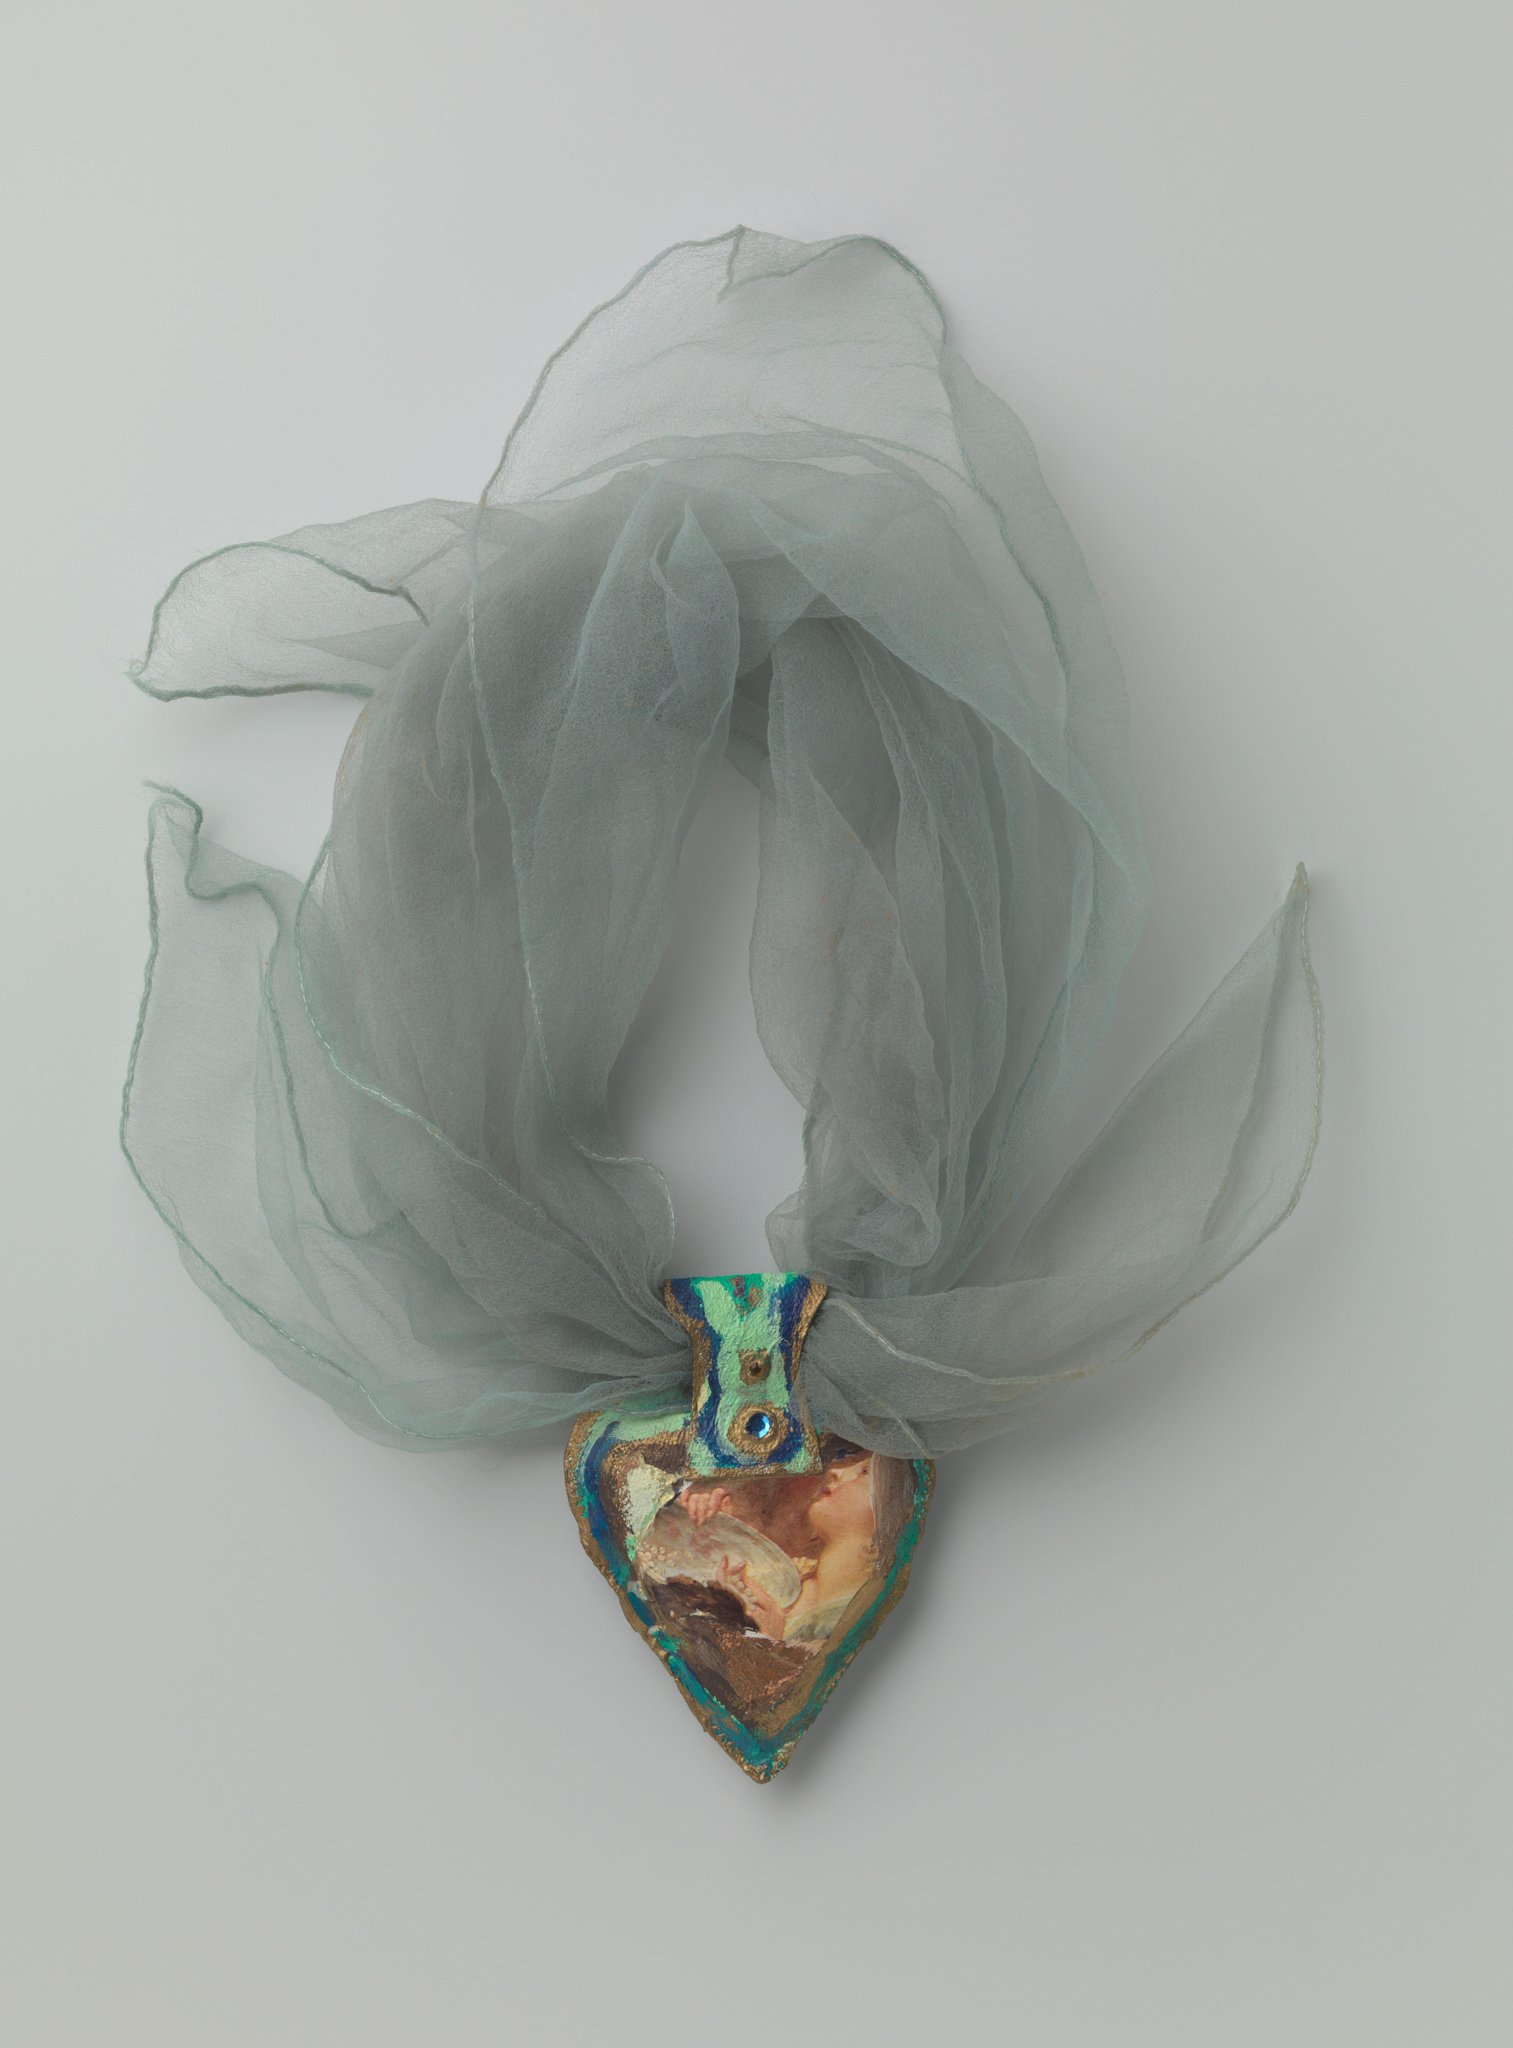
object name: necklace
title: Collier met hart van textiel en papier maché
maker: petra hartman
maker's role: designer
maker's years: 1960-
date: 1990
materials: glass, paint, papier mâché, textile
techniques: knotting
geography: netherlands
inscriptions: signature: ‘Petra’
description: Halssieraad van gaasachtig groen aan de uiteinden aaneengeknoopt textiel met daaraan een hartvormige hanger van beschilderd papier maché met een ronde gele gefacetteerde steen van glas, daaronder een ronde gefacetteerde steen van blauw glas en een fragment van een reproductie van een schilderij.